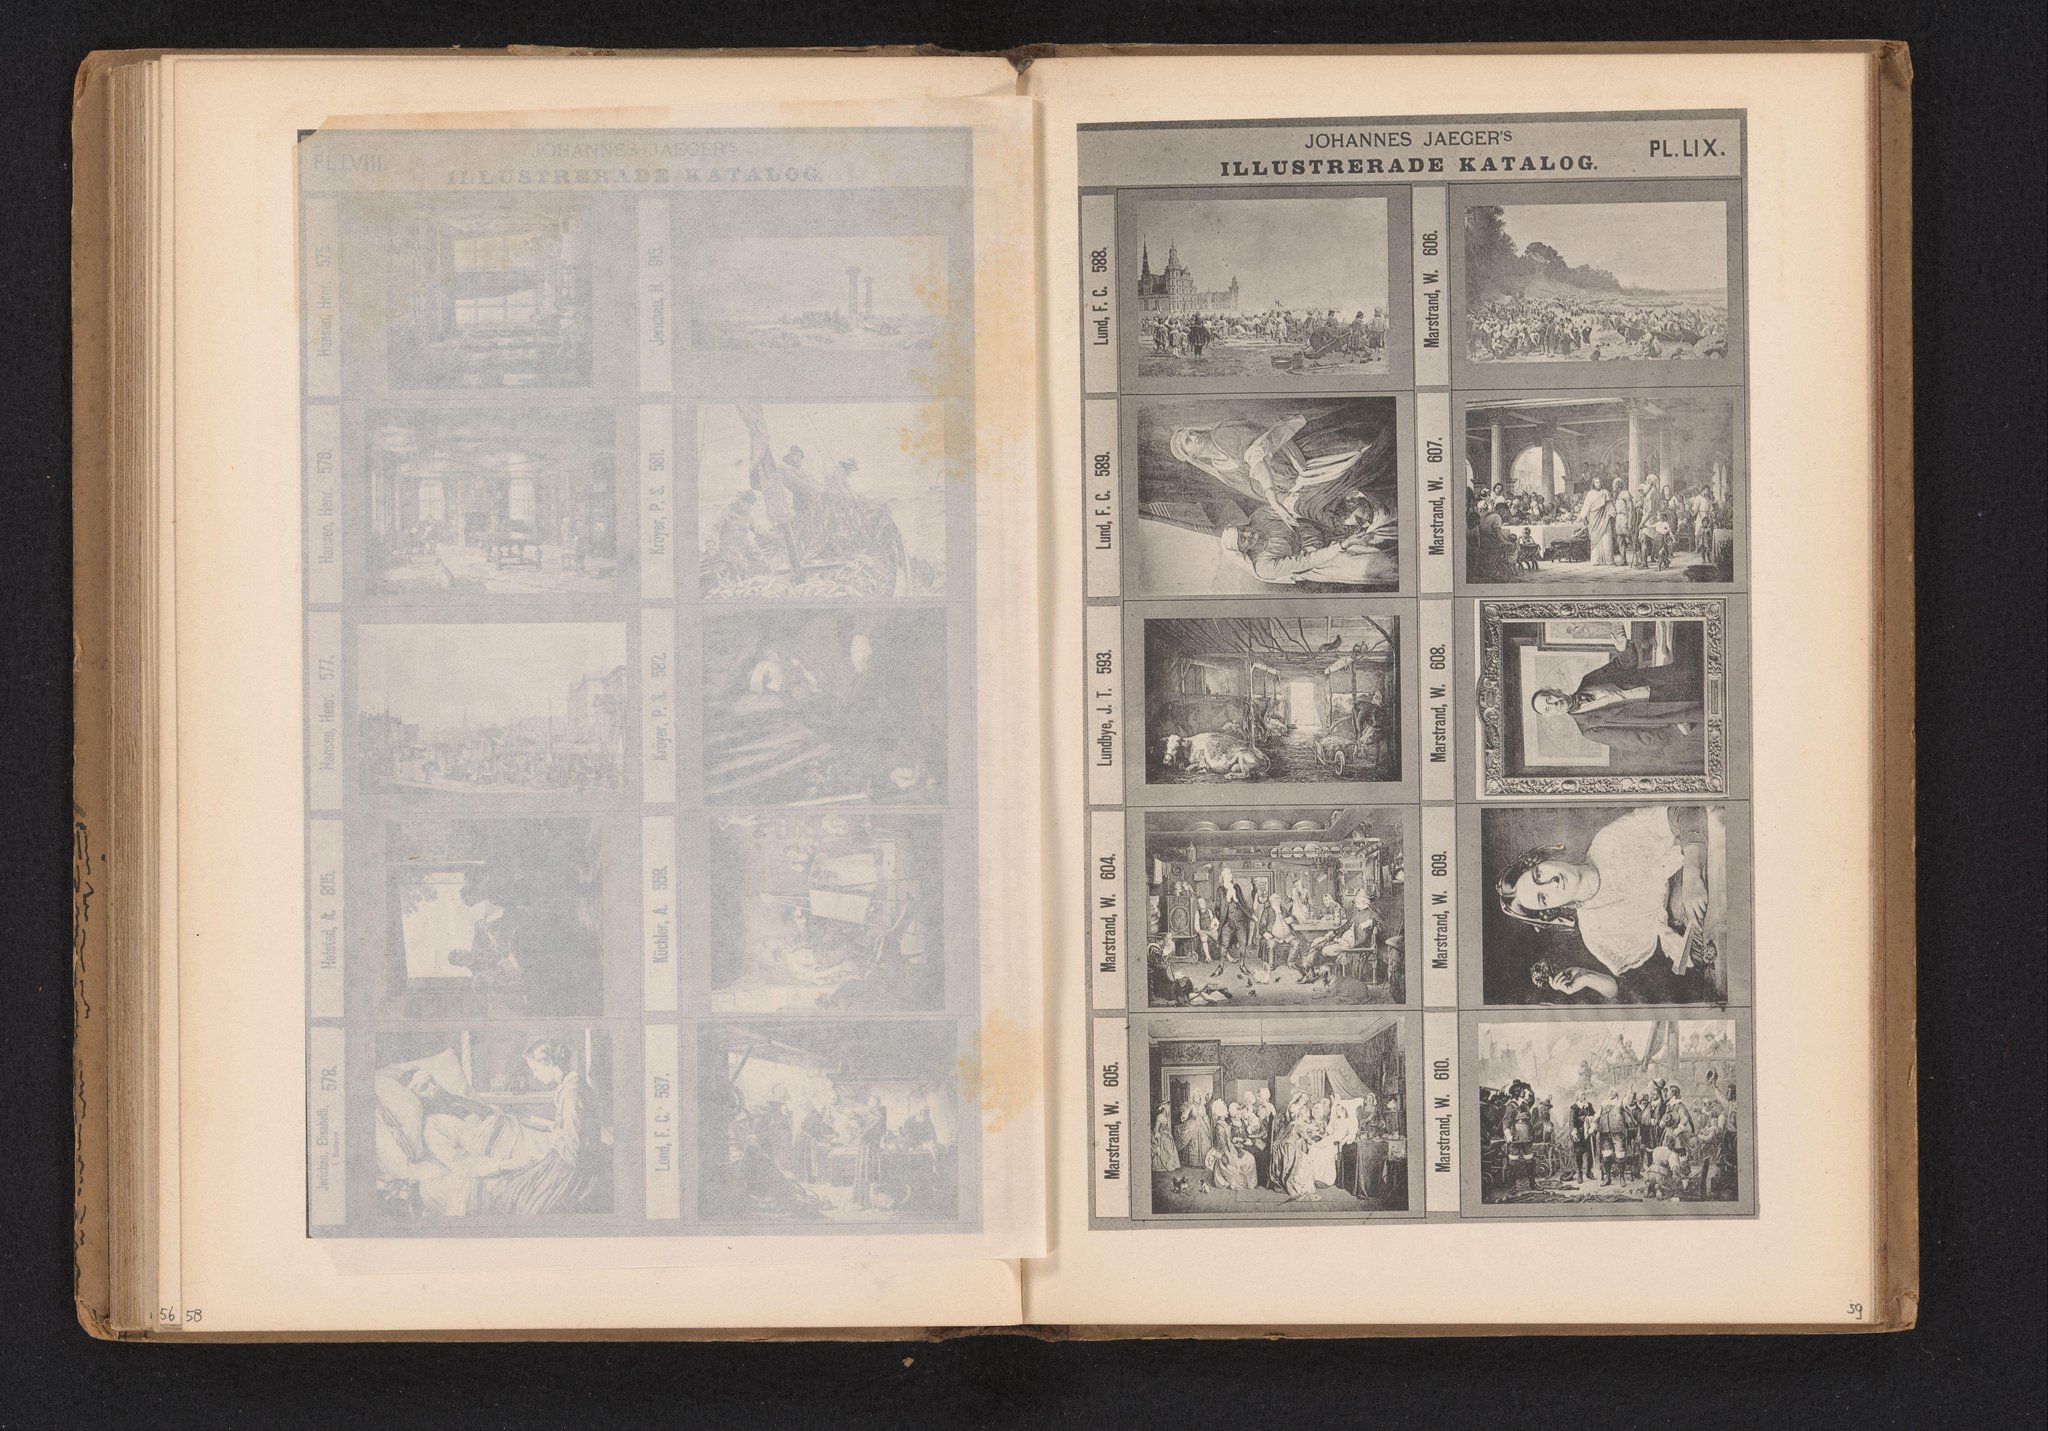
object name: photomechanical print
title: Fotoreproductie van tien schilderijen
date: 1872-1882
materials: paper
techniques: photograph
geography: stockholm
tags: picture, painting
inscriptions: number: ‘PL. LIX.’